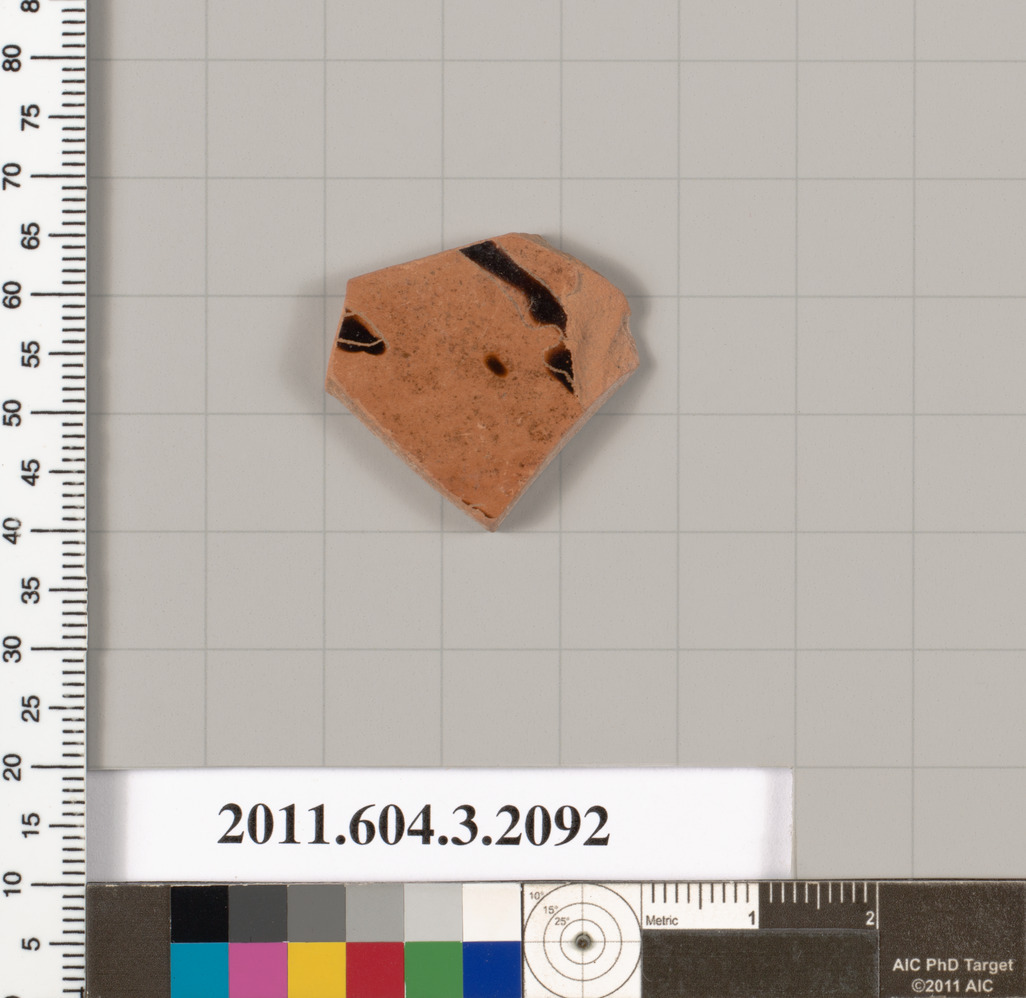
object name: kylix fragment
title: Terracotta fragment of a kylix (drinking cup)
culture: greek, attic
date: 534-468 BCE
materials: terracotta